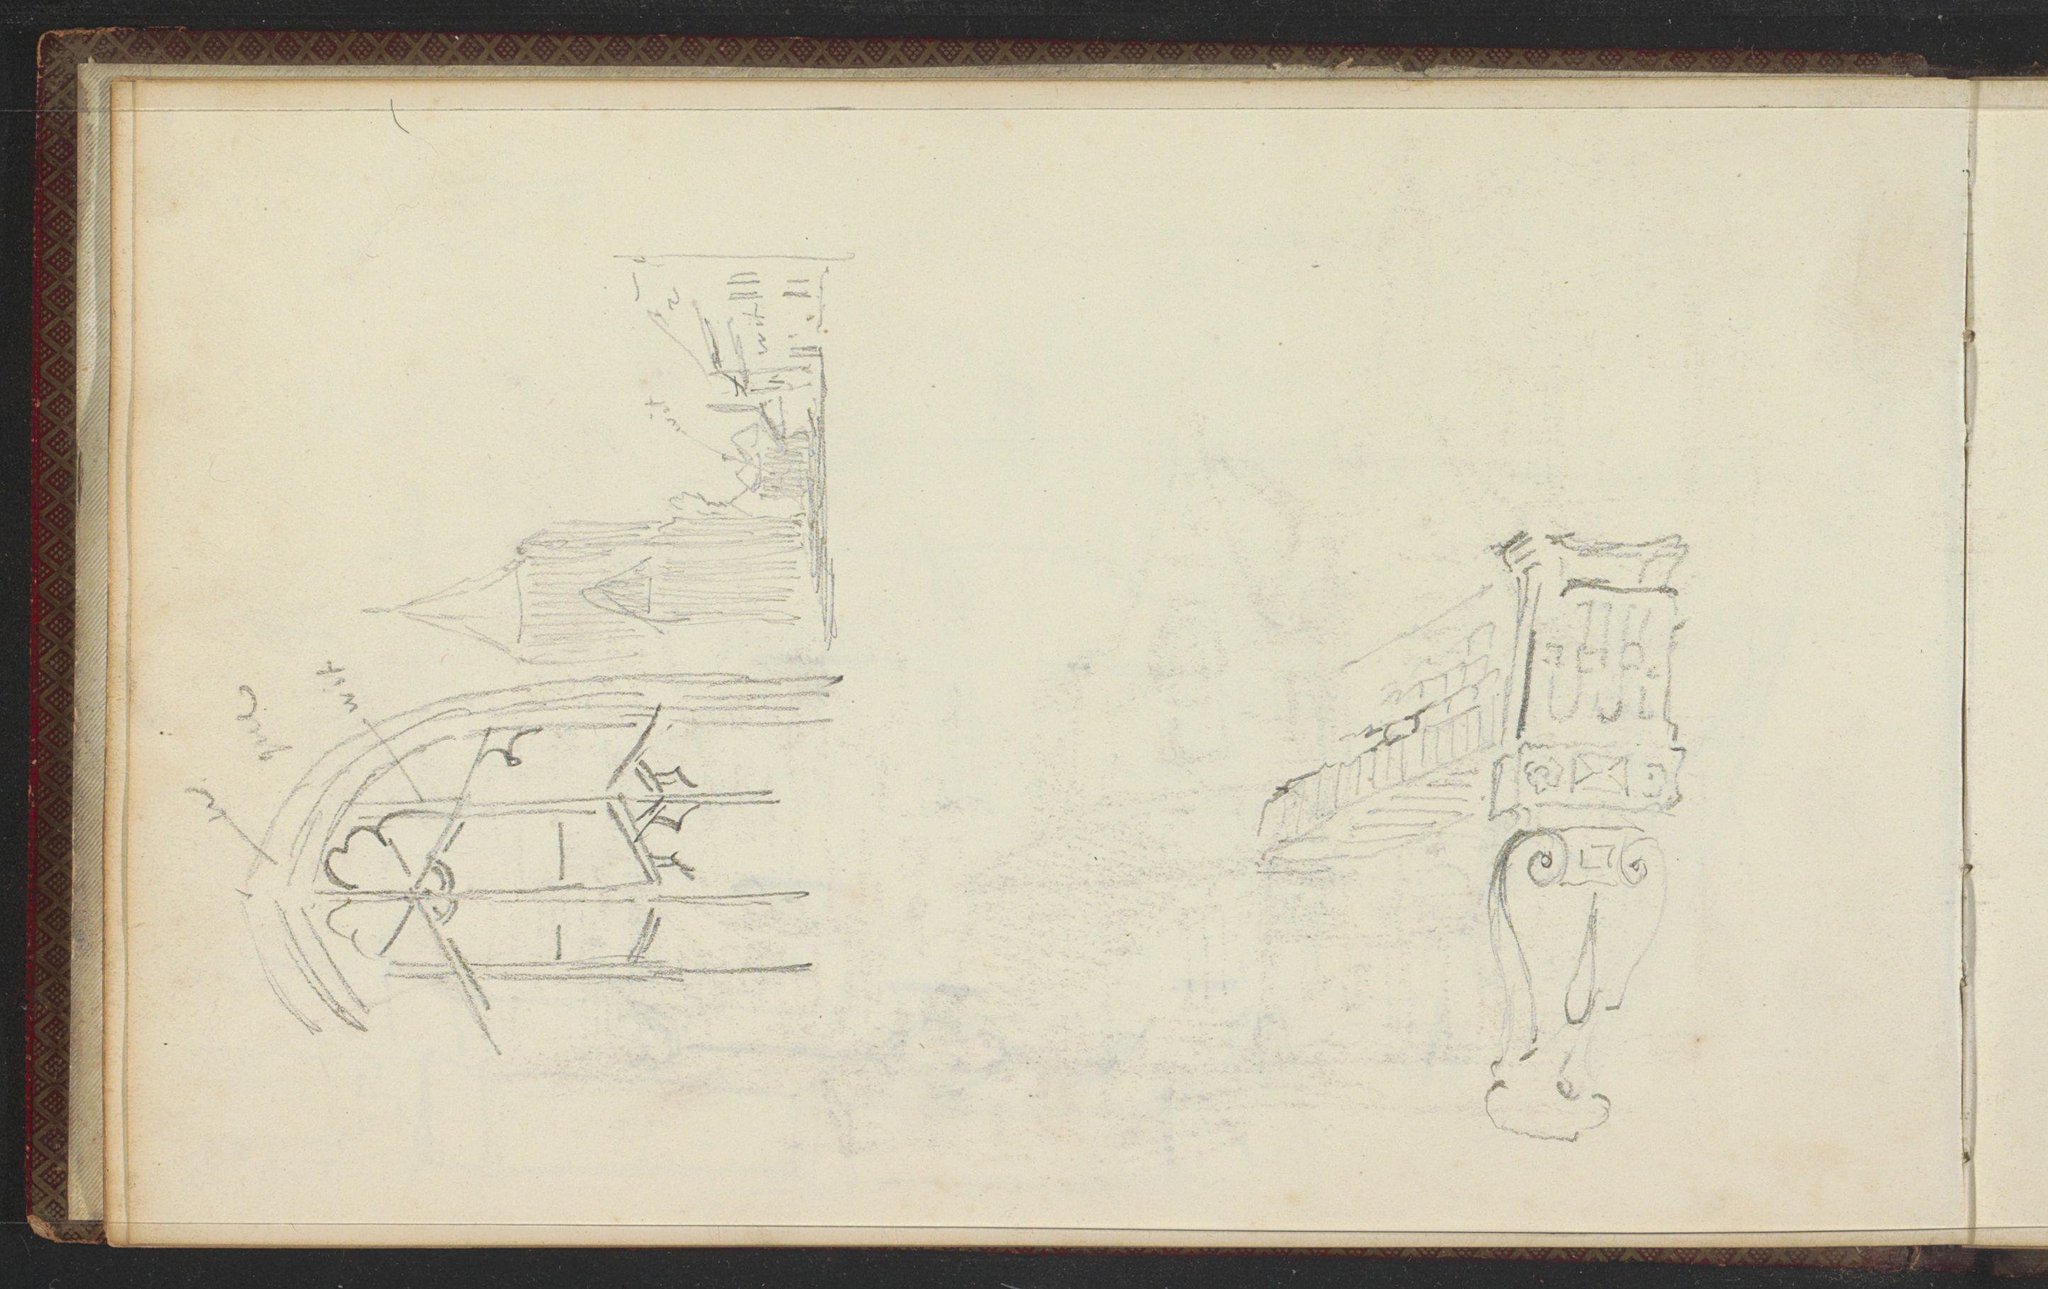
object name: sketchbook leaf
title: Architectuurstudies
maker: adrianus eversen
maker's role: draughtsman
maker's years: 1818-1897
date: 1828-1897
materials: paper, pencil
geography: netherlands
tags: church-window, e.g. rose-window, architectural detail, fence, wall, paling, church (exterior), street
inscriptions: kleurnotitie, handgeschreven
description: Linksboven een boogvenster en daarnaast een gezicht op een straat met een kerk. Onder een muur met een decoratief element. Blad 6 verso uit een schetsboek met 52 bladen vervaardigd in de omgeving van Kampen, Hattem, Hoorn en Zwolle.